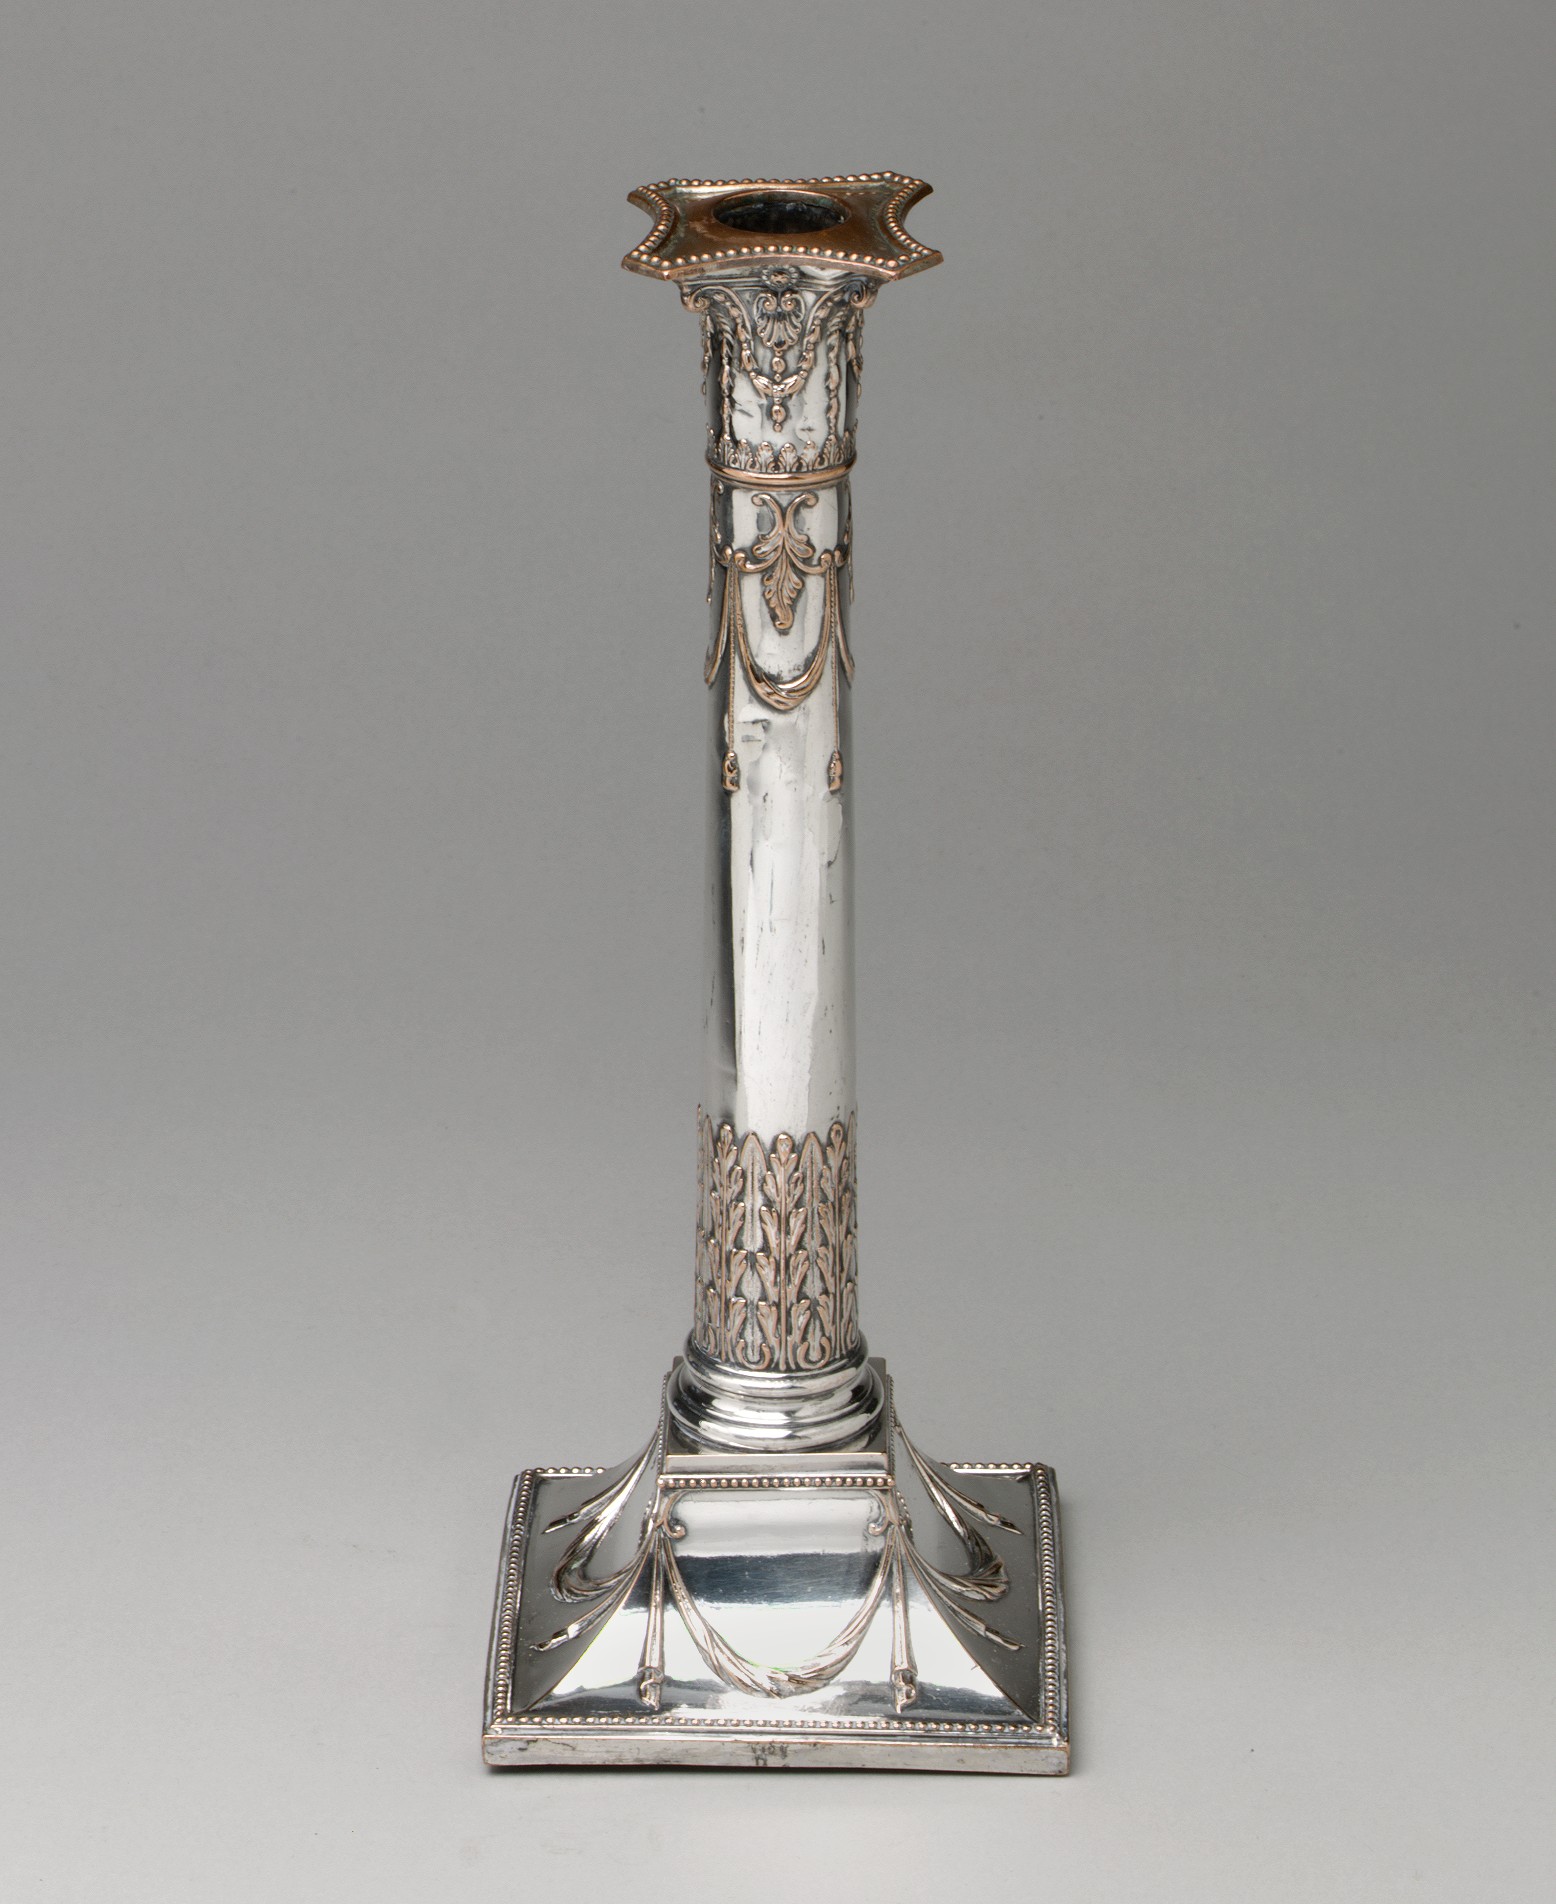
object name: candlestick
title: Candlestick (one of a pair)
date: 1775-1780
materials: metal